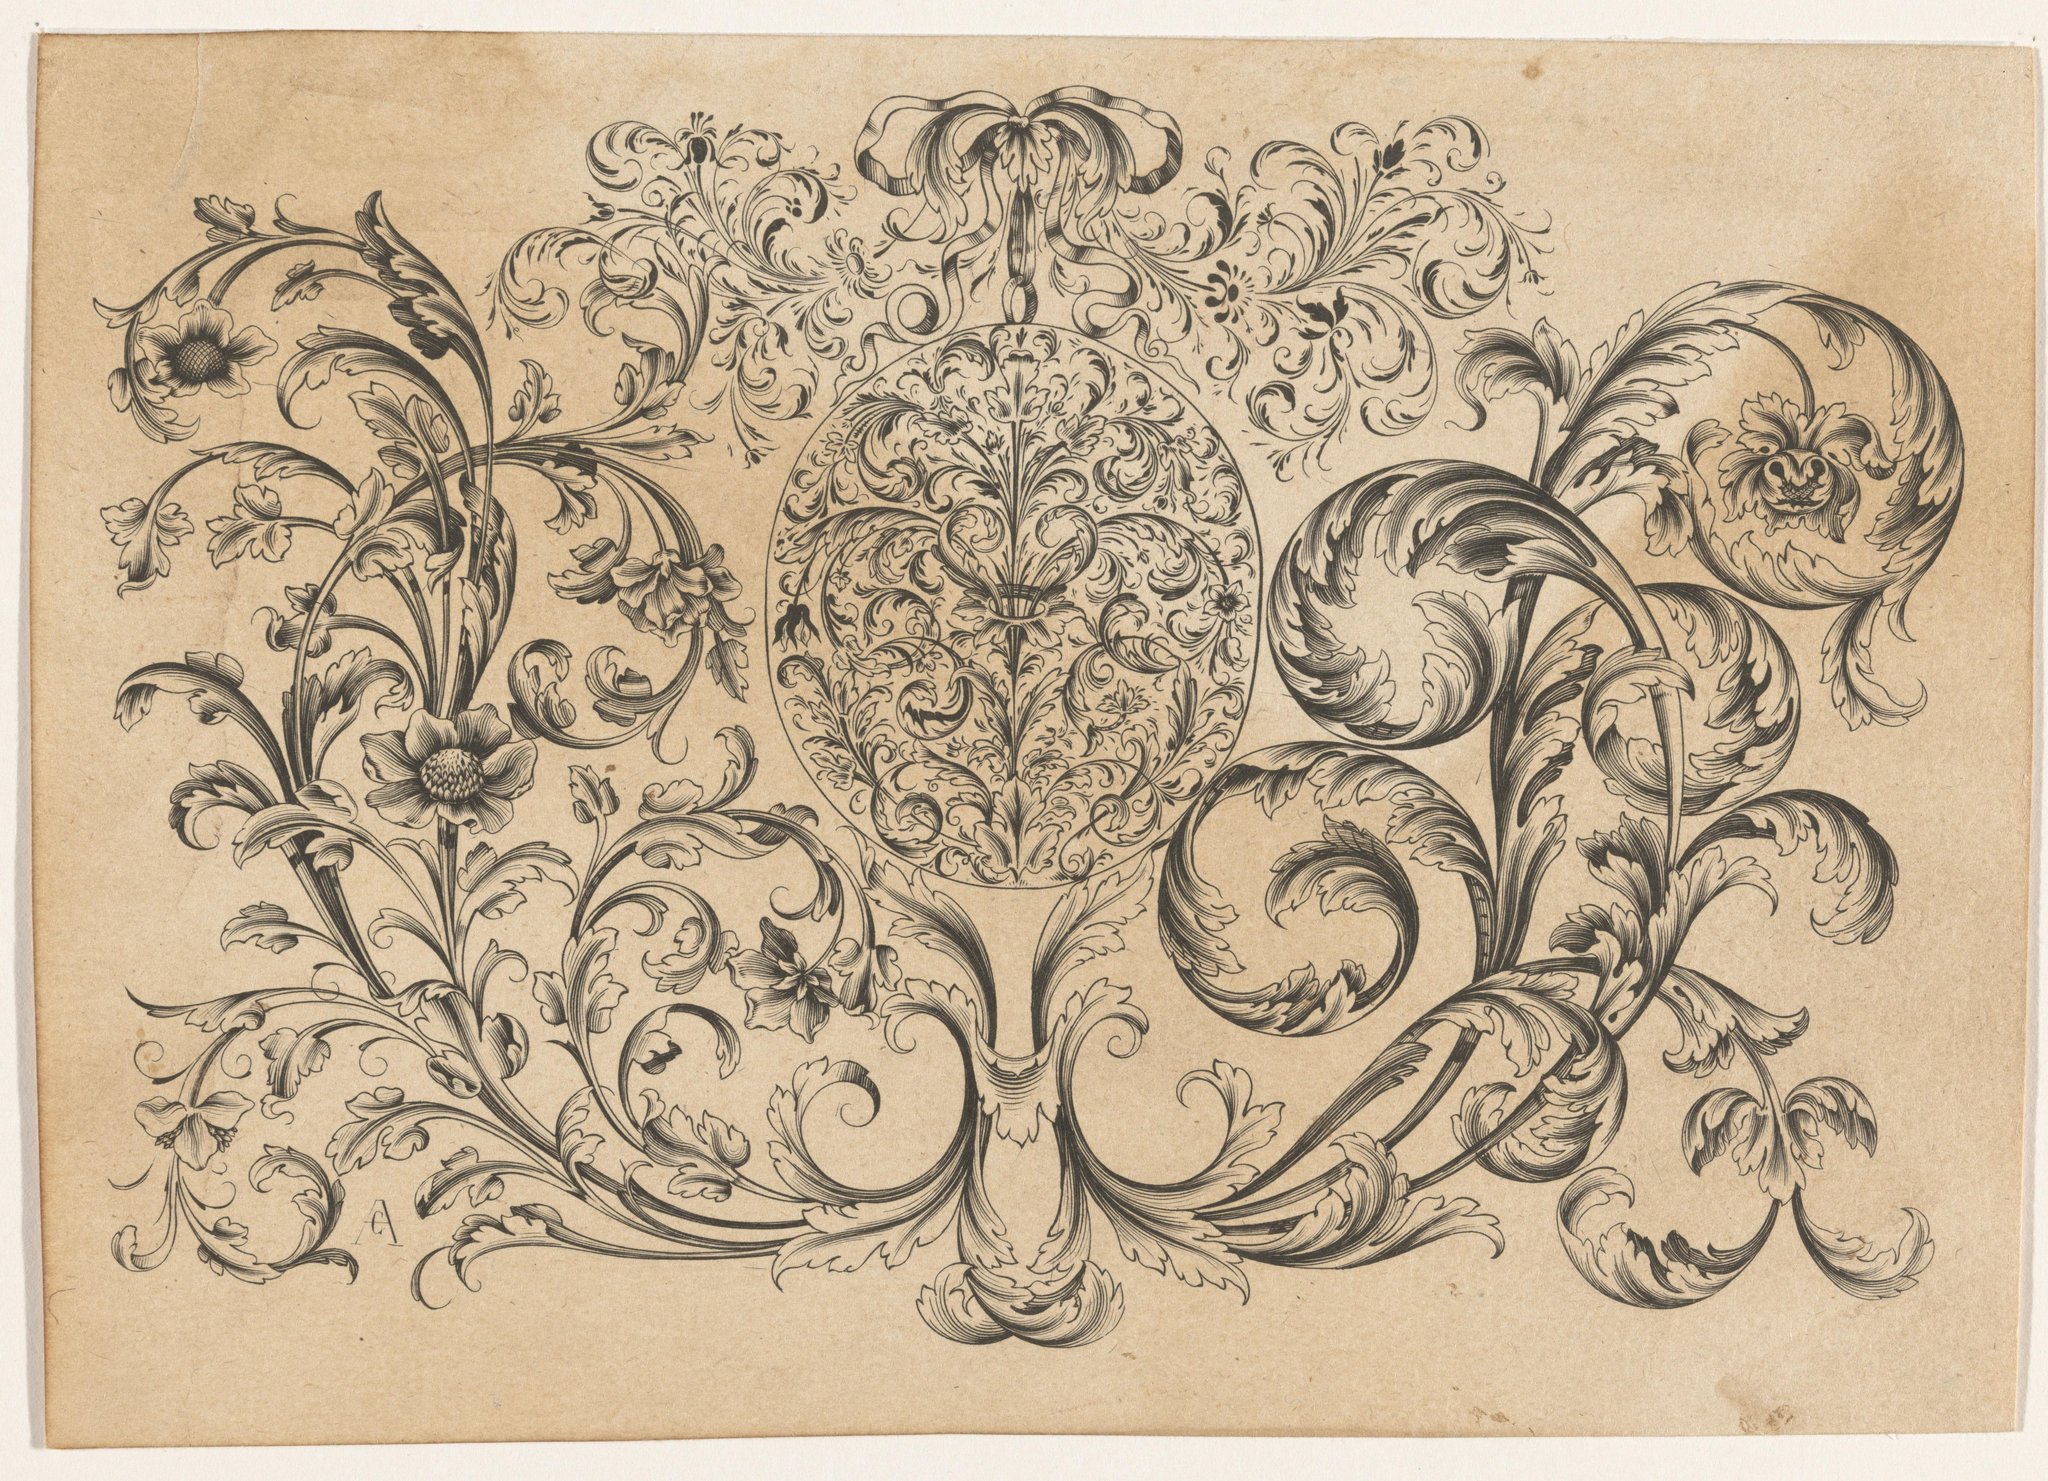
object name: print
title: Ornament voor goud- en zilversmeden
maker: monogrammist ac (graveur)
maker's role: print maker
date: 1580-1700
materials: paper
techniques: engraving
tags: ornaments ~ art, foliage ~ ornament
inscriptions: monogram: ‘AC’, collector's mark: Lugt 2760, collector's mark: Lugt 2228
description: Ontwerp bestaande uit ranken omringt met gestileerde bladeren en bloemen, erboven een strik.